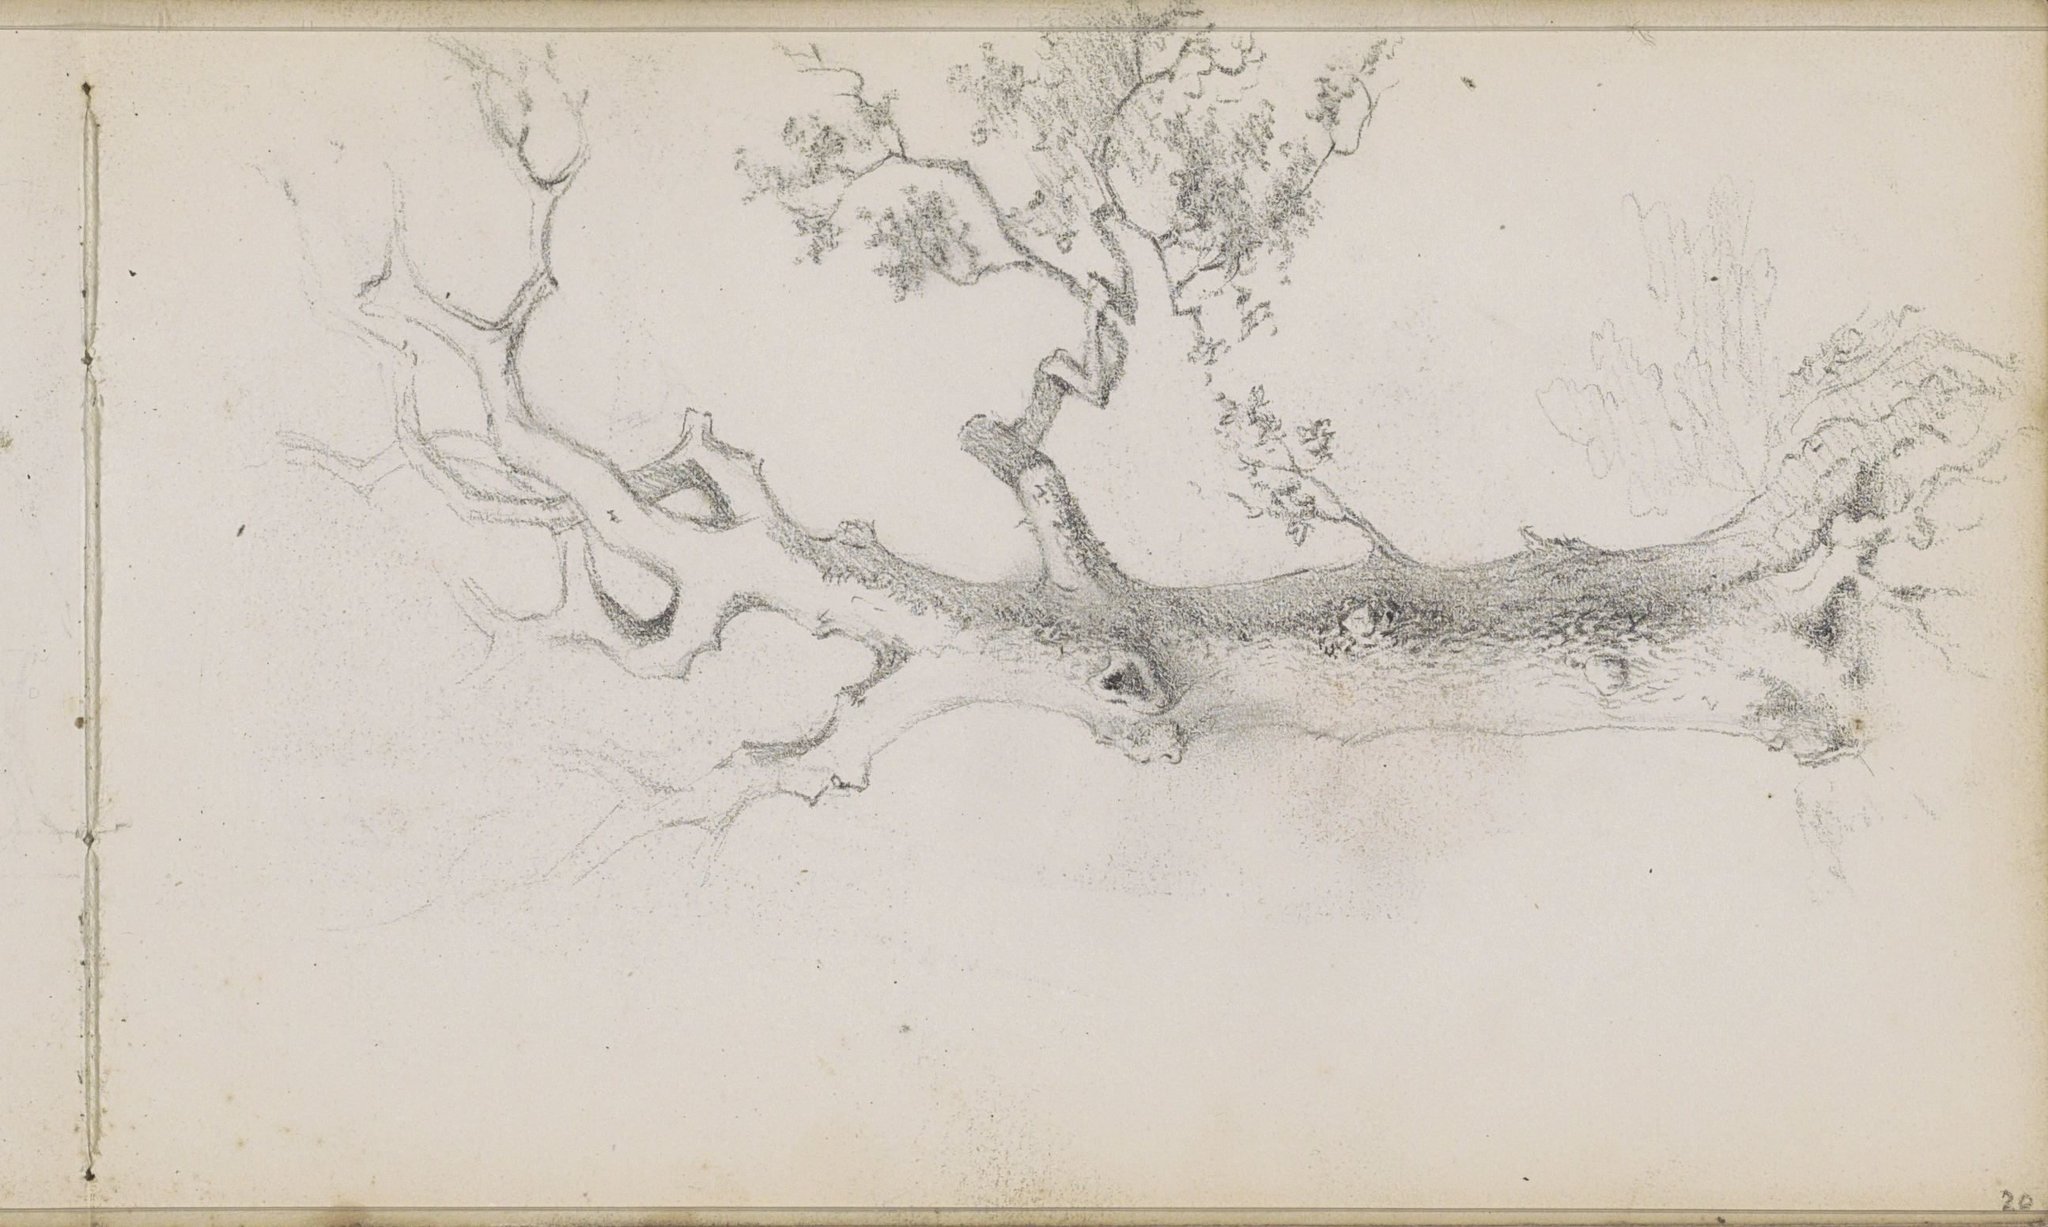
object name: sketchbook leaf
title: Boom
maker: willem cornelis rip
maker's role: draughtsman, painter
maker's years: 1856-1922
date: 1874-1875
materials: paper, pencil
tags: trees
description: Blad 20 recto uit een schetsboek met 46 bladen.